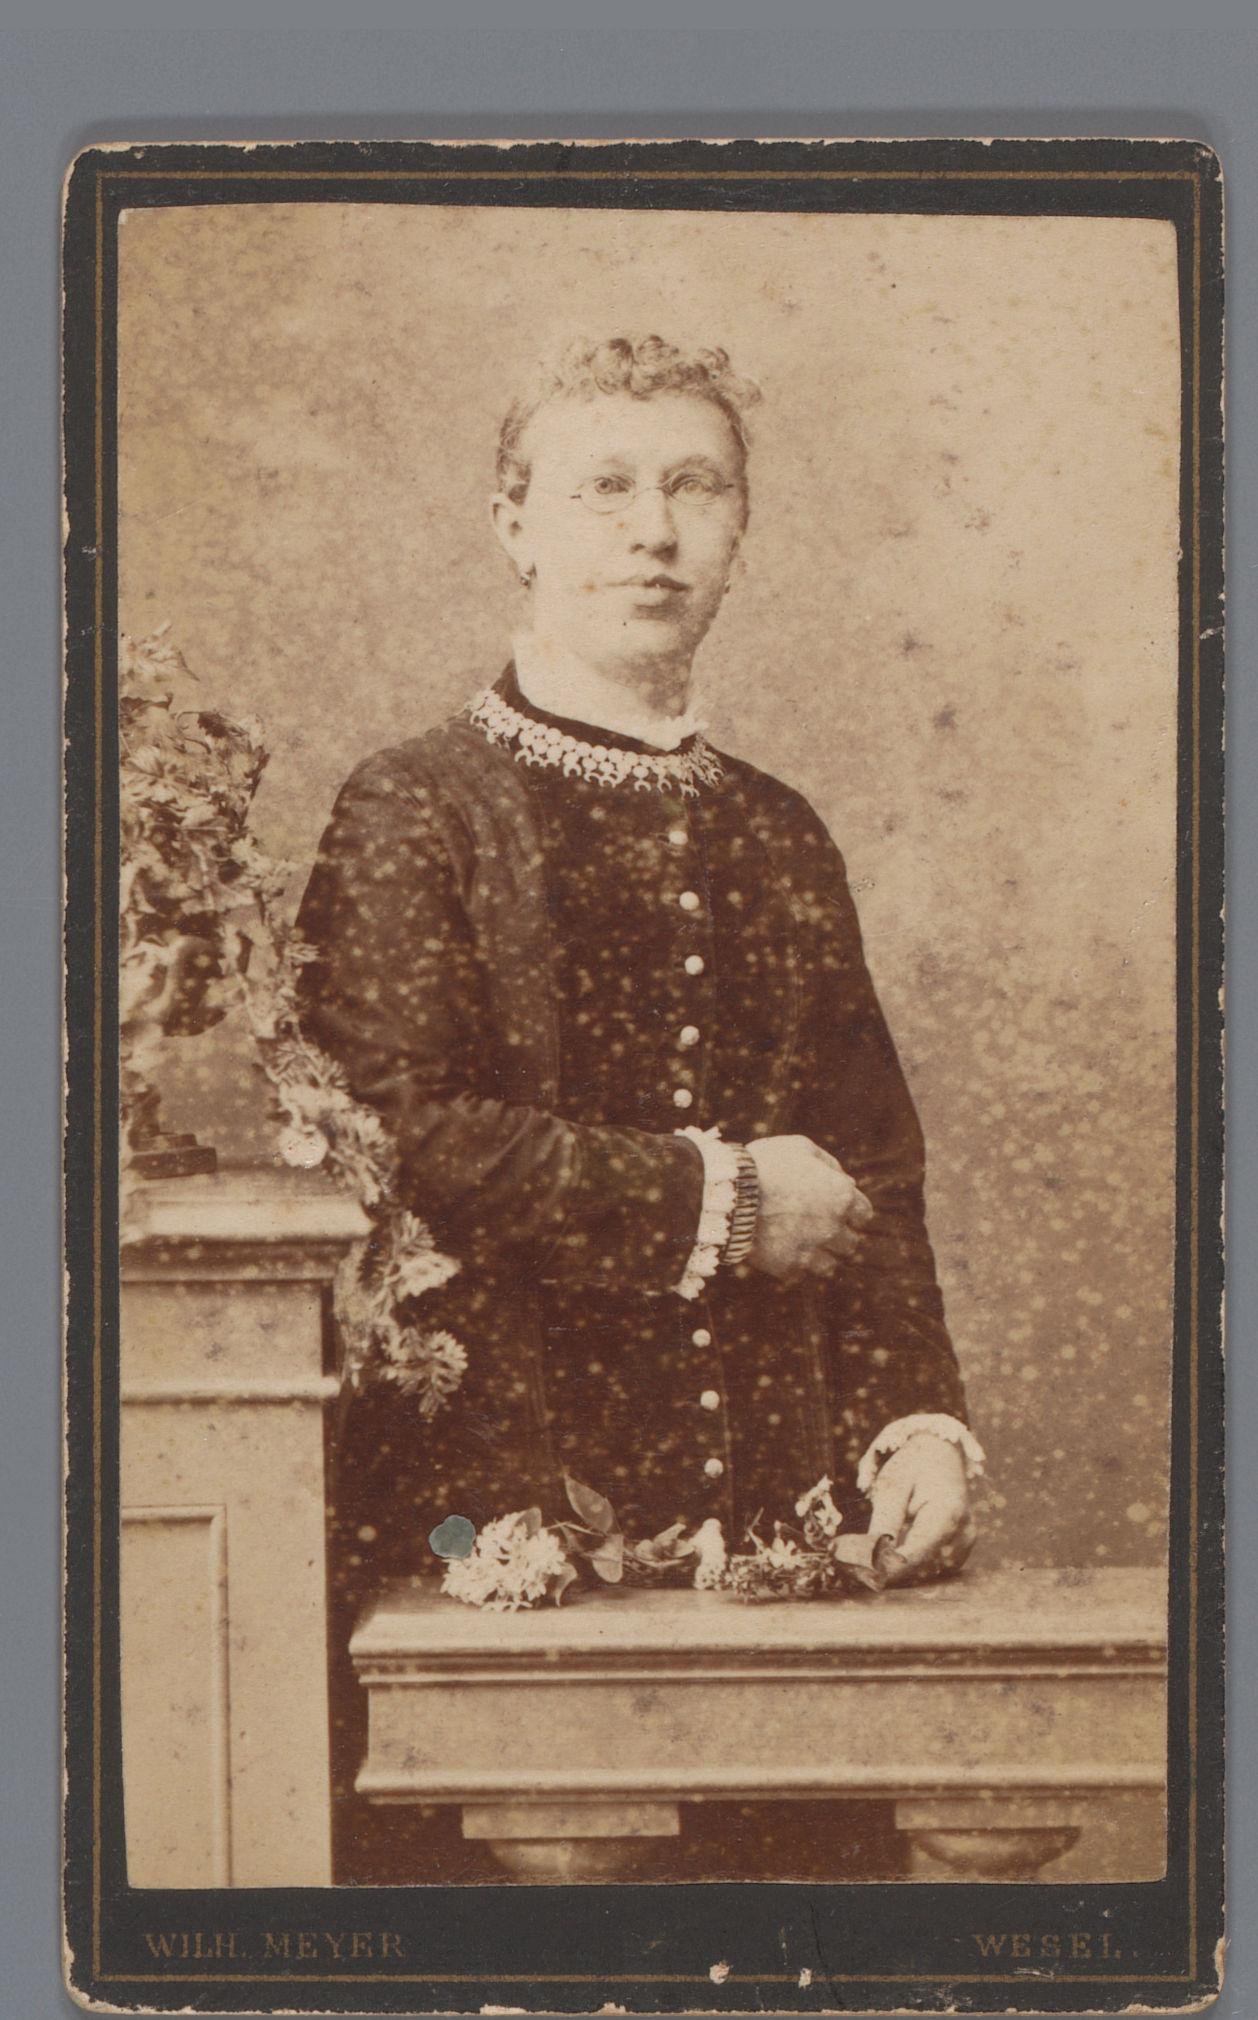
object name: photograph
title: Portret van een onbekende vrouw met bril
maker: wilhelm meyer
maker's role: fotograaf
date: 1870-1885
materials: cardboard, paper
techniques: albumen print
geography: wezel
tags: historical persons - bb - woman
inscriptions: inscription: ‘PHOTOGRAPHIE ATELIER/ VON/ Wilh. Meyer/ WESEL/ Baustrasse No. 642./ Die Originalplatte wird für Nachbestellung aufbewahrt.’